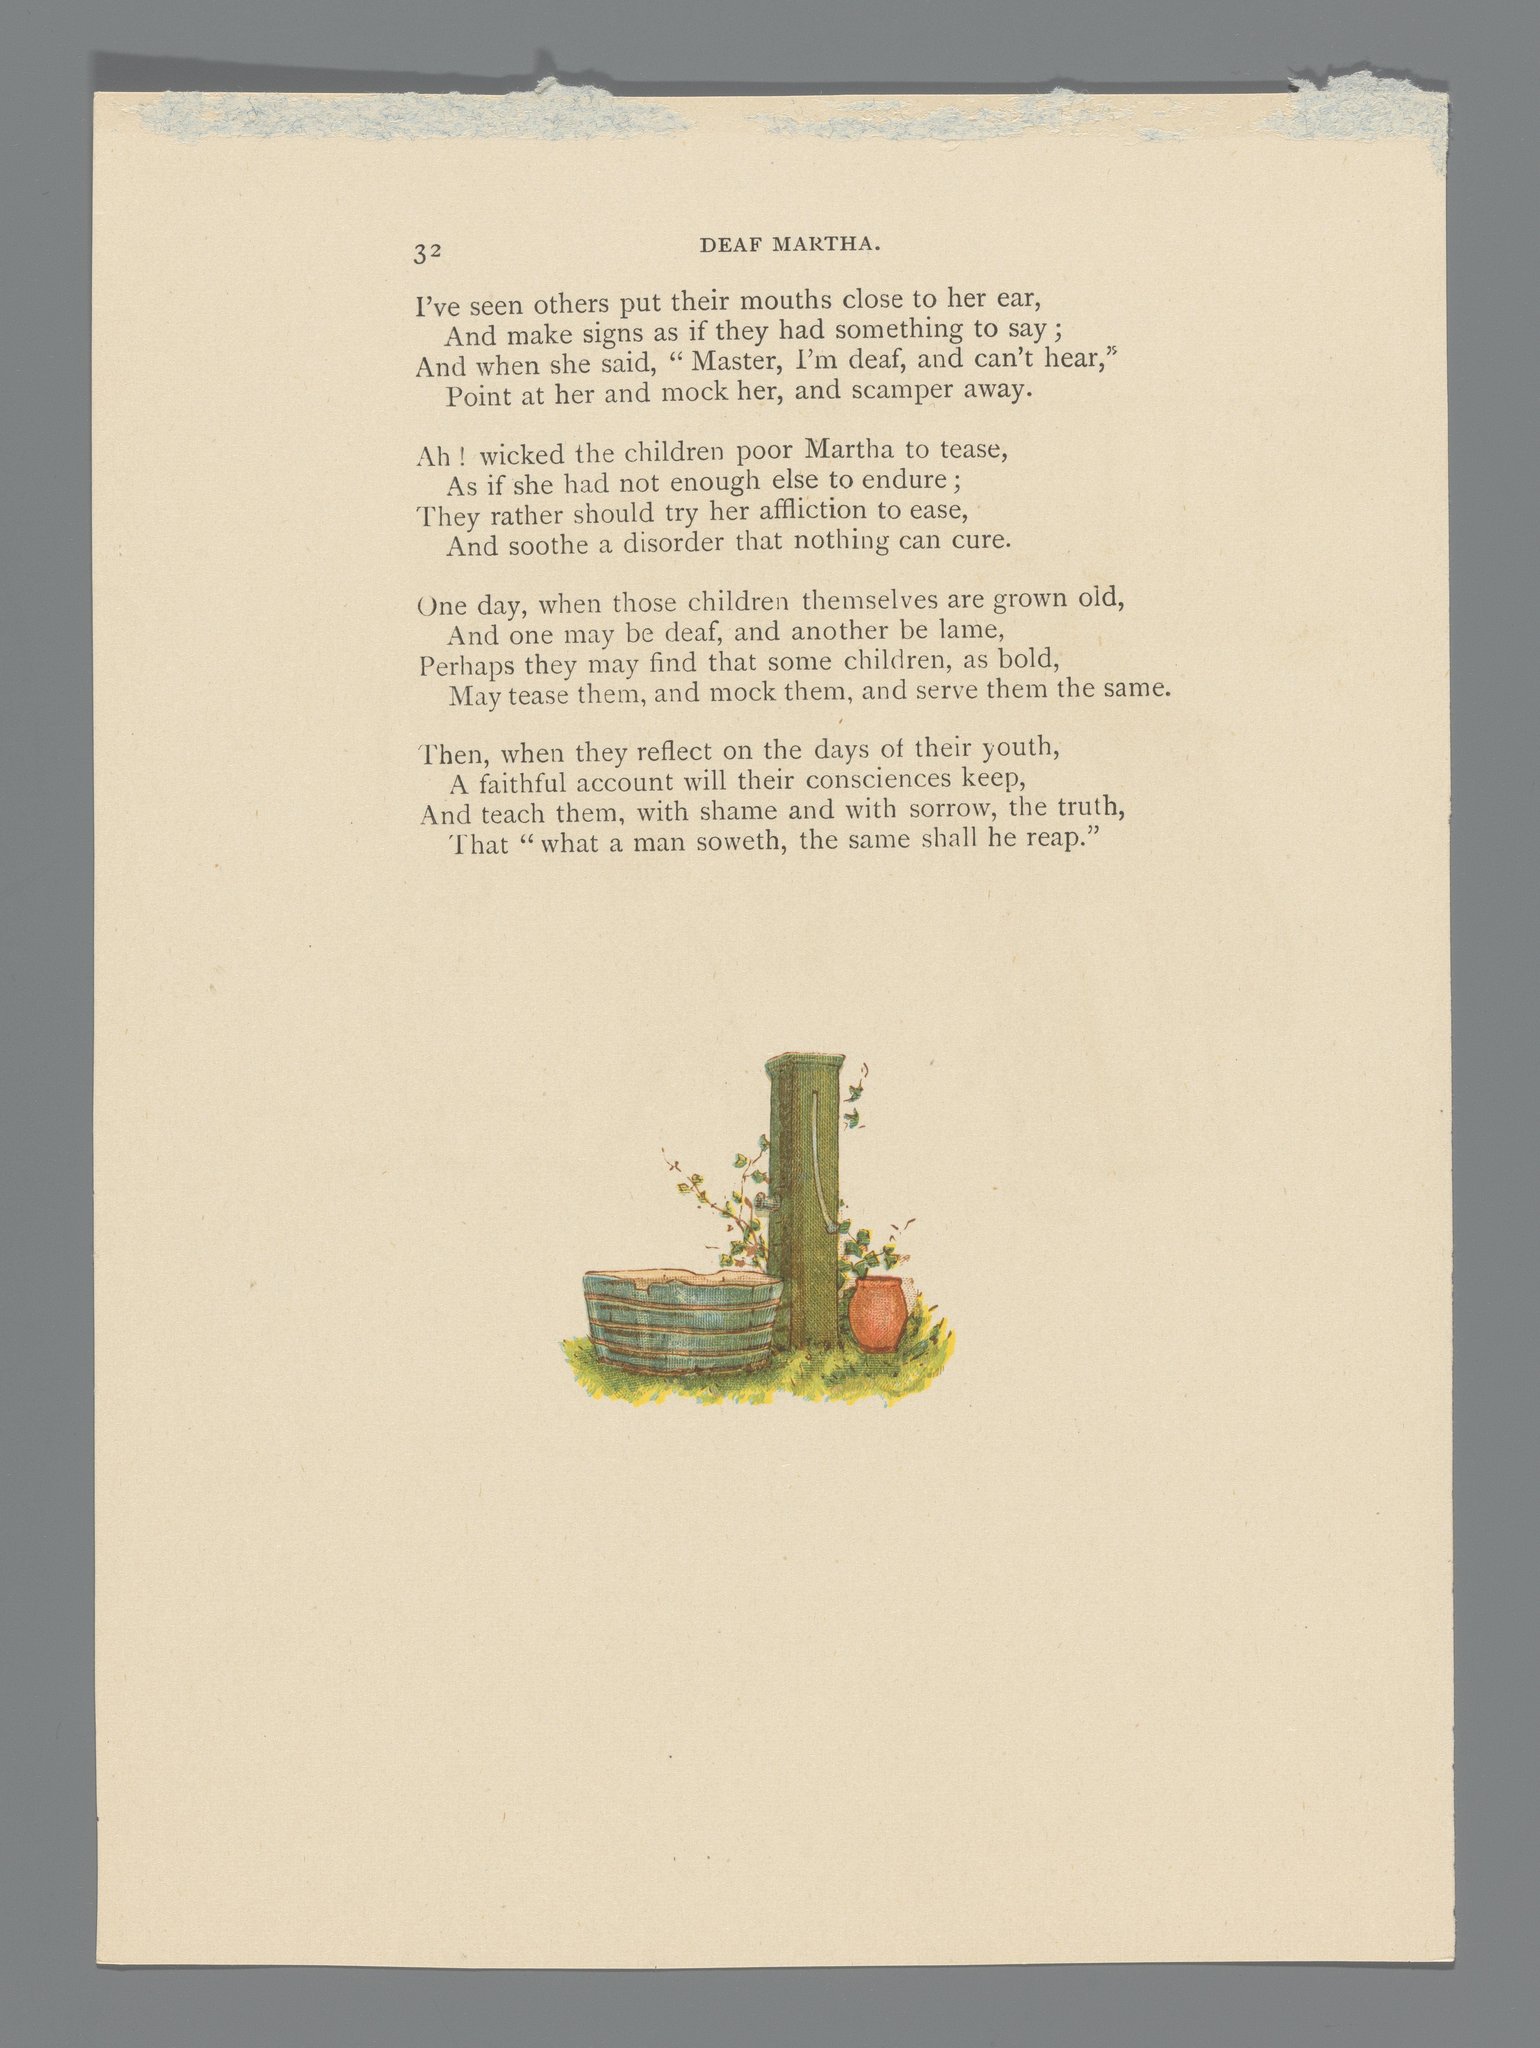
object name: print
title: Kuip bij een waterpomp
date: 1883-1927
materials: paper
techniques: wood engraving, letterpress printing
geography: london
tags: wooden container: barrel, cask, bucket, water-supply (~ public services), utilitarian, public pump or water fountain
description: Prent uit: Jane en Ann Taylor. Little Ann and other poems. Londen: George Routledge & Sons, [1883], p. 32. Of een latere uitgave.